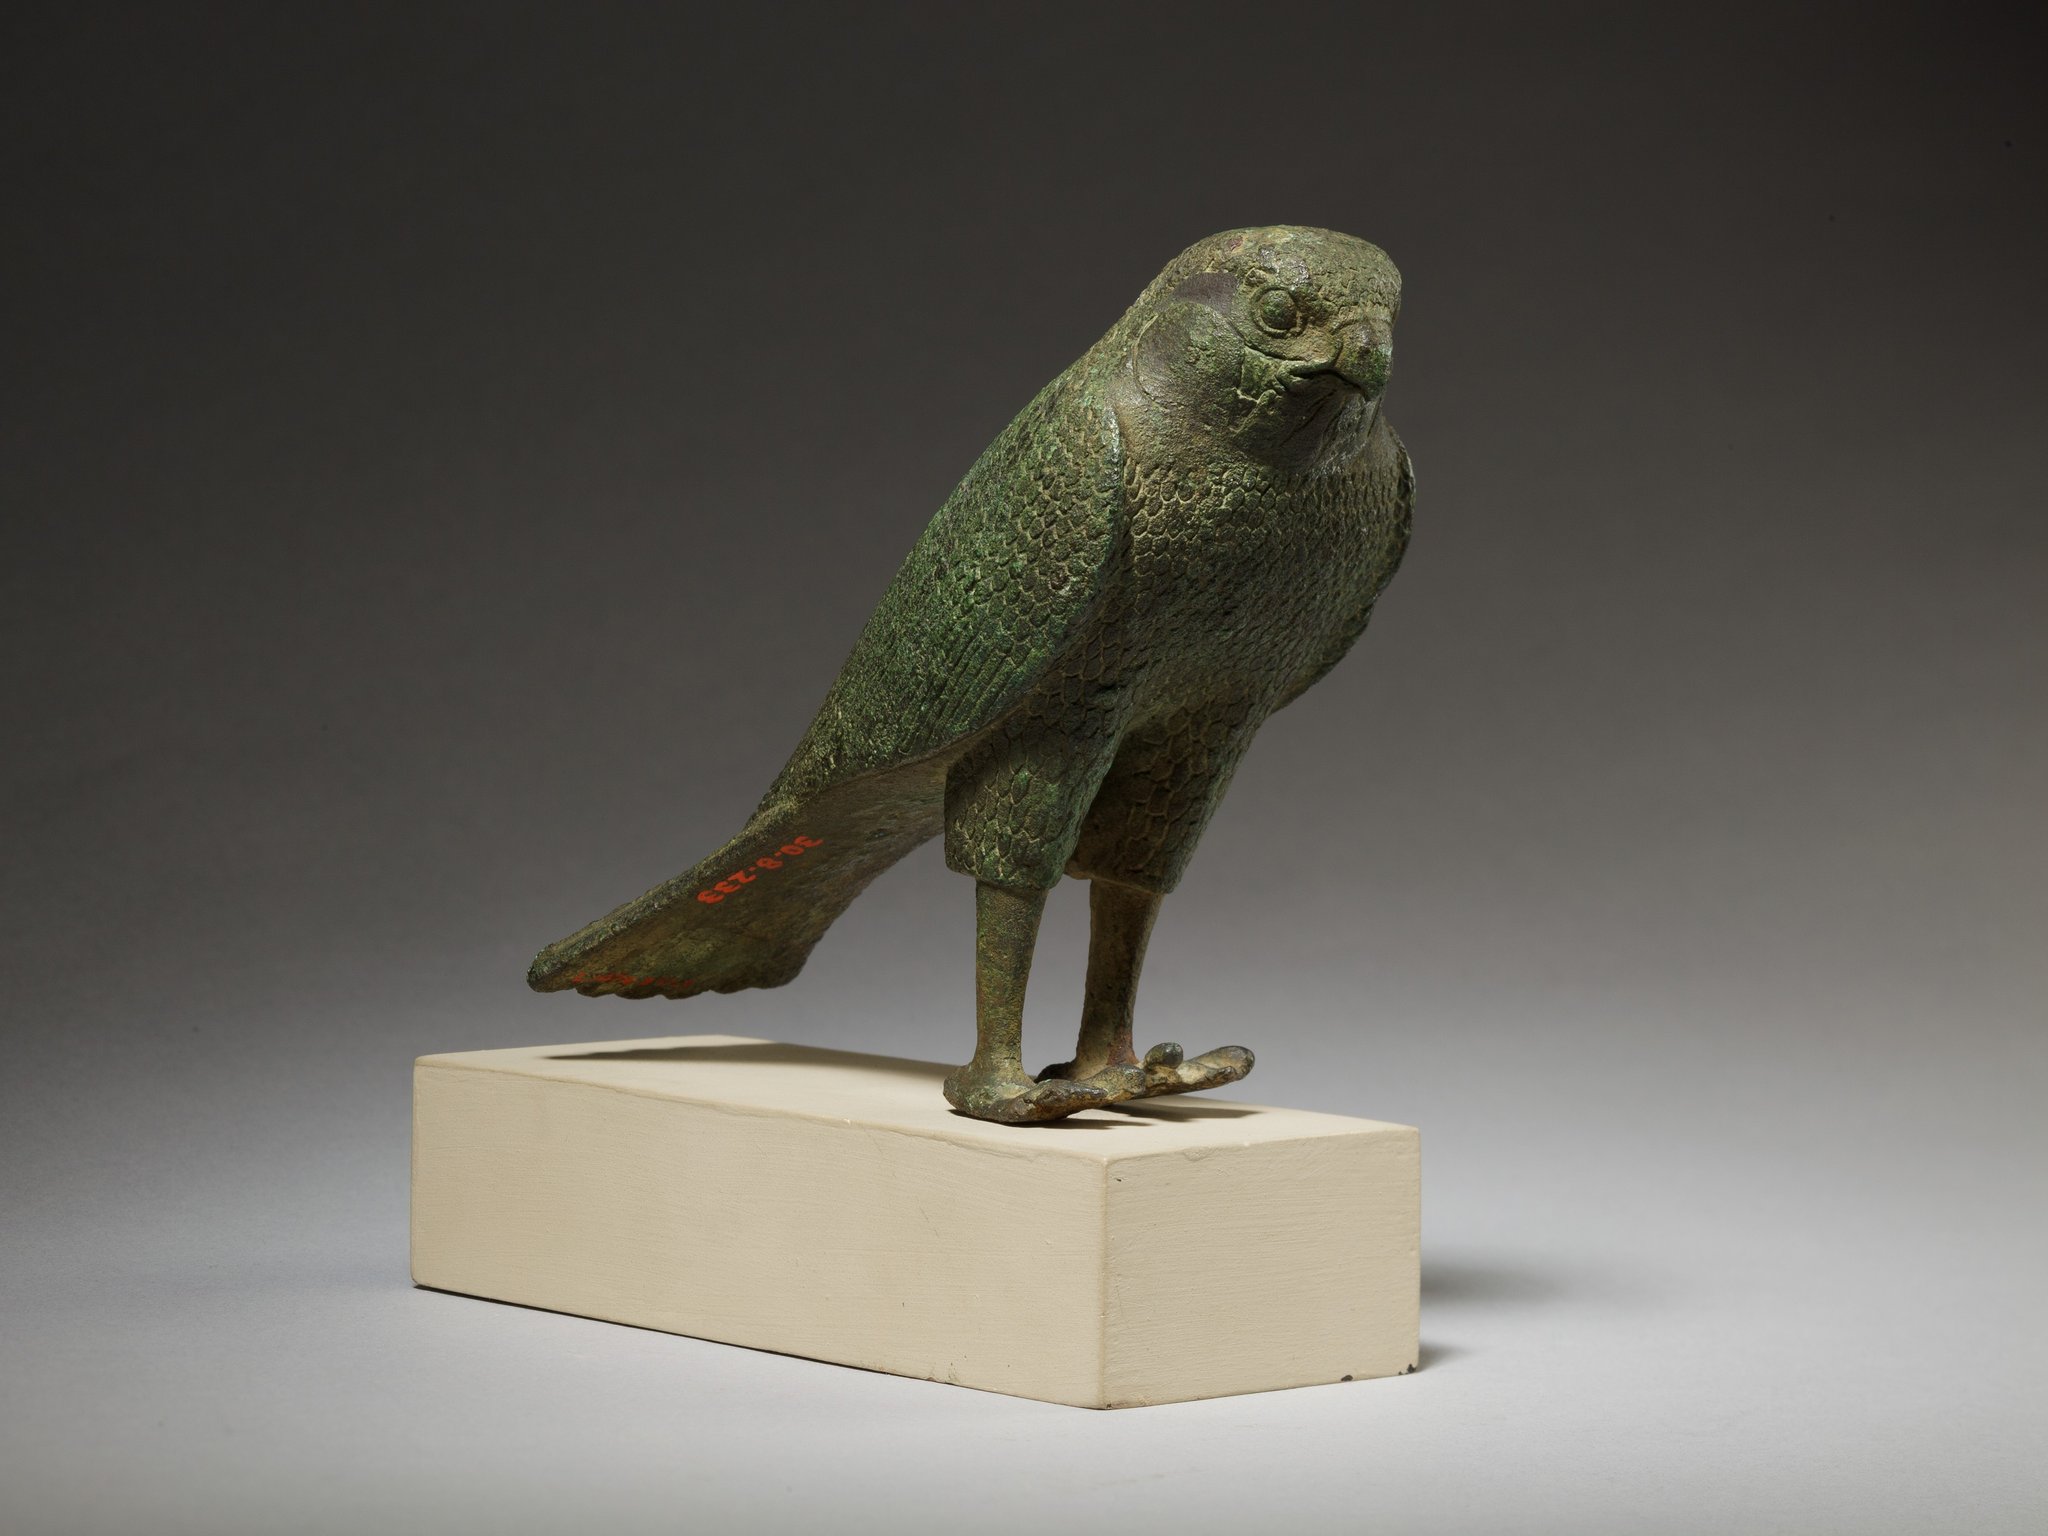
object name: figurine, falcon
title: Falcon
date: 664-630 BCE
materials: metal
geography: egypt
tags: falcons